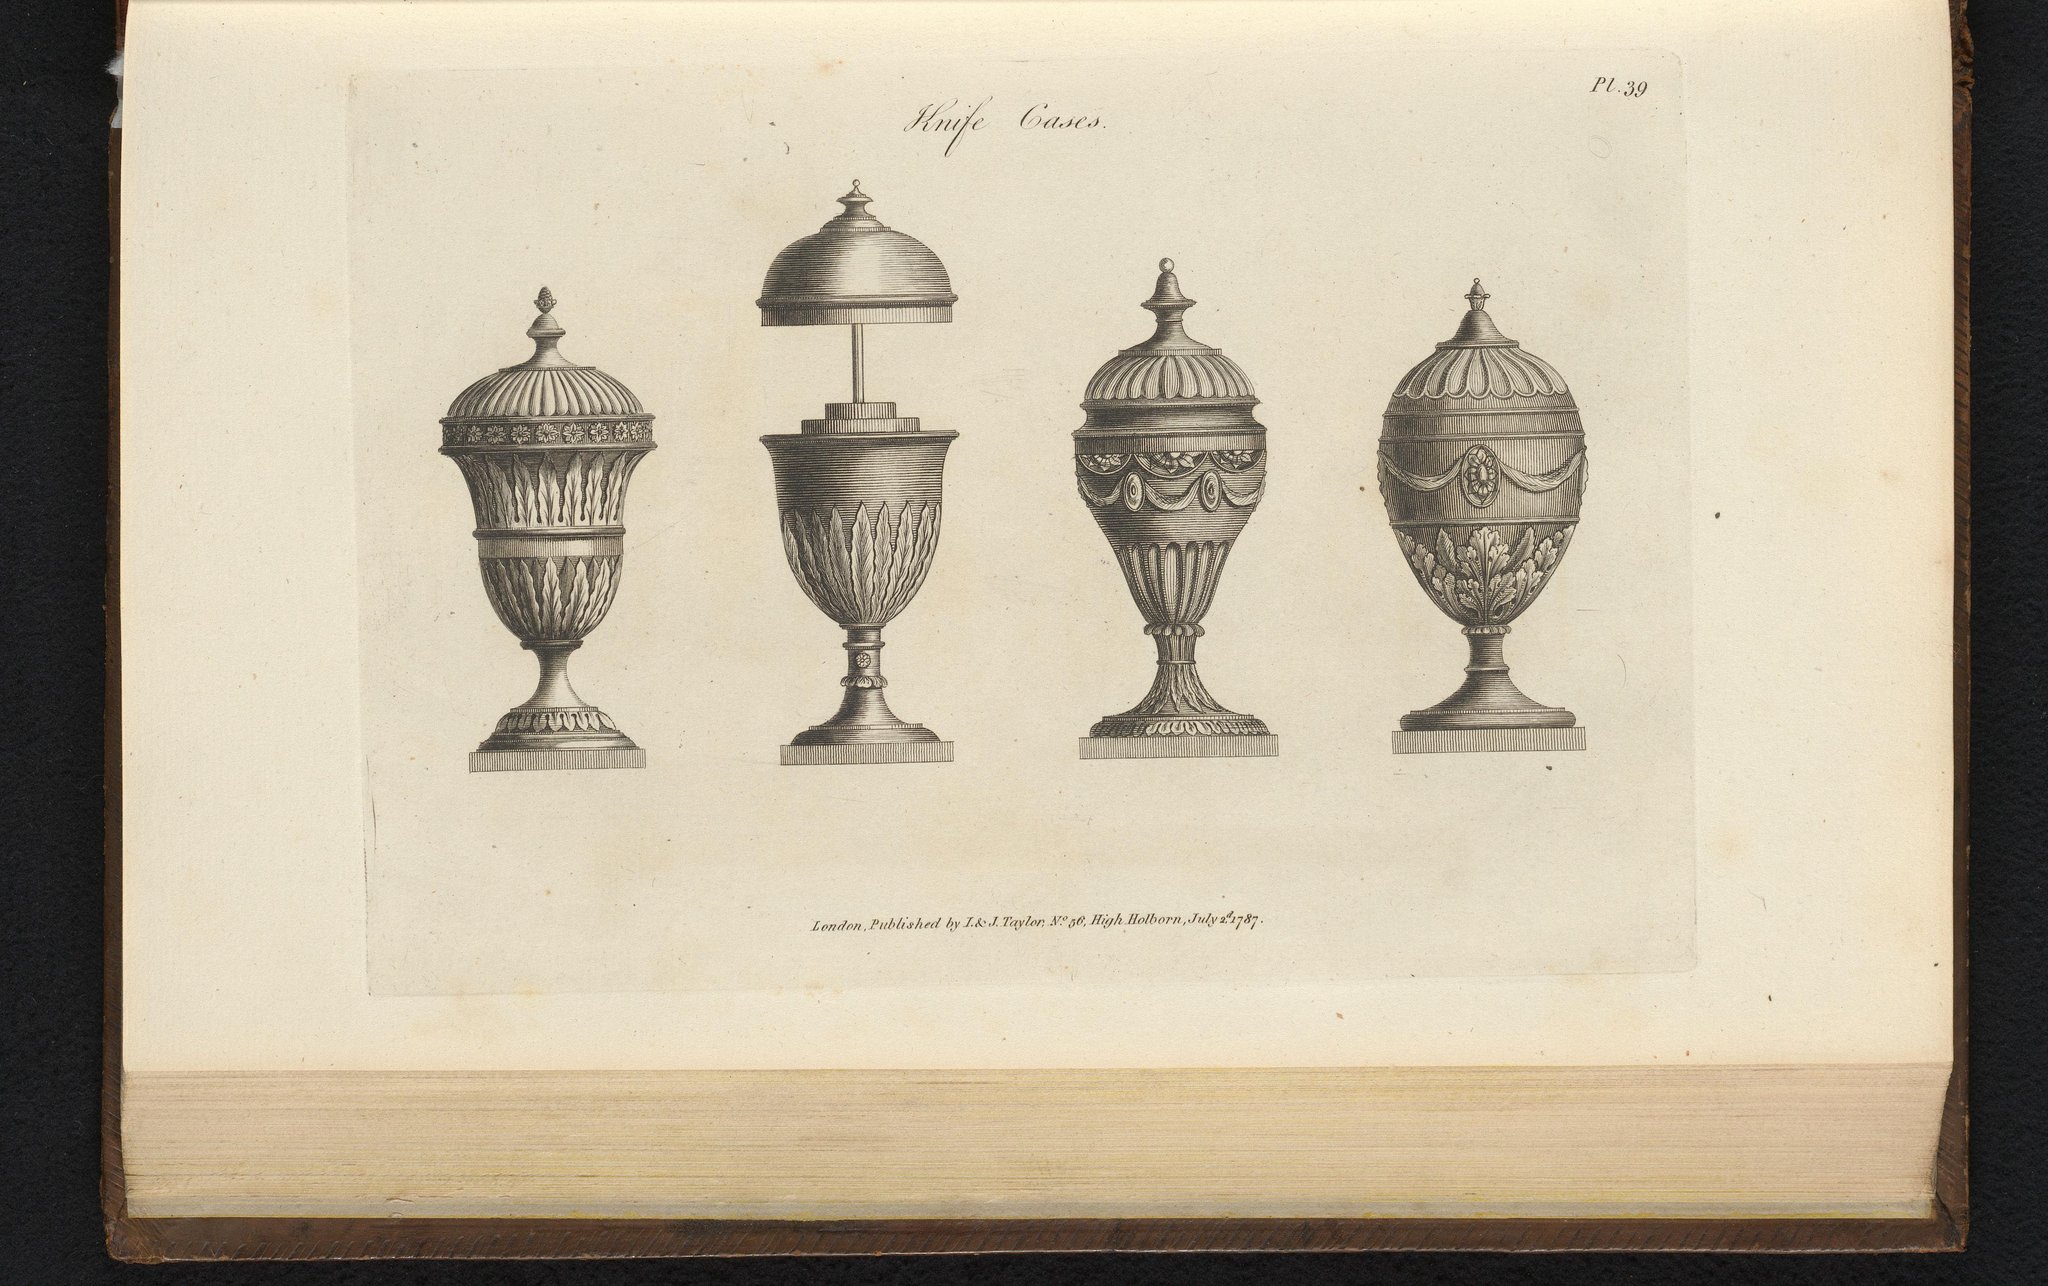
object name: page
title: Knife Cases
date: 1787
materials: paper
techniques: engraving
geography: holborn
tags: container of stone: stone vase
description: Genummerd: Pl. 39. Prent maakt deel uit van een boek.